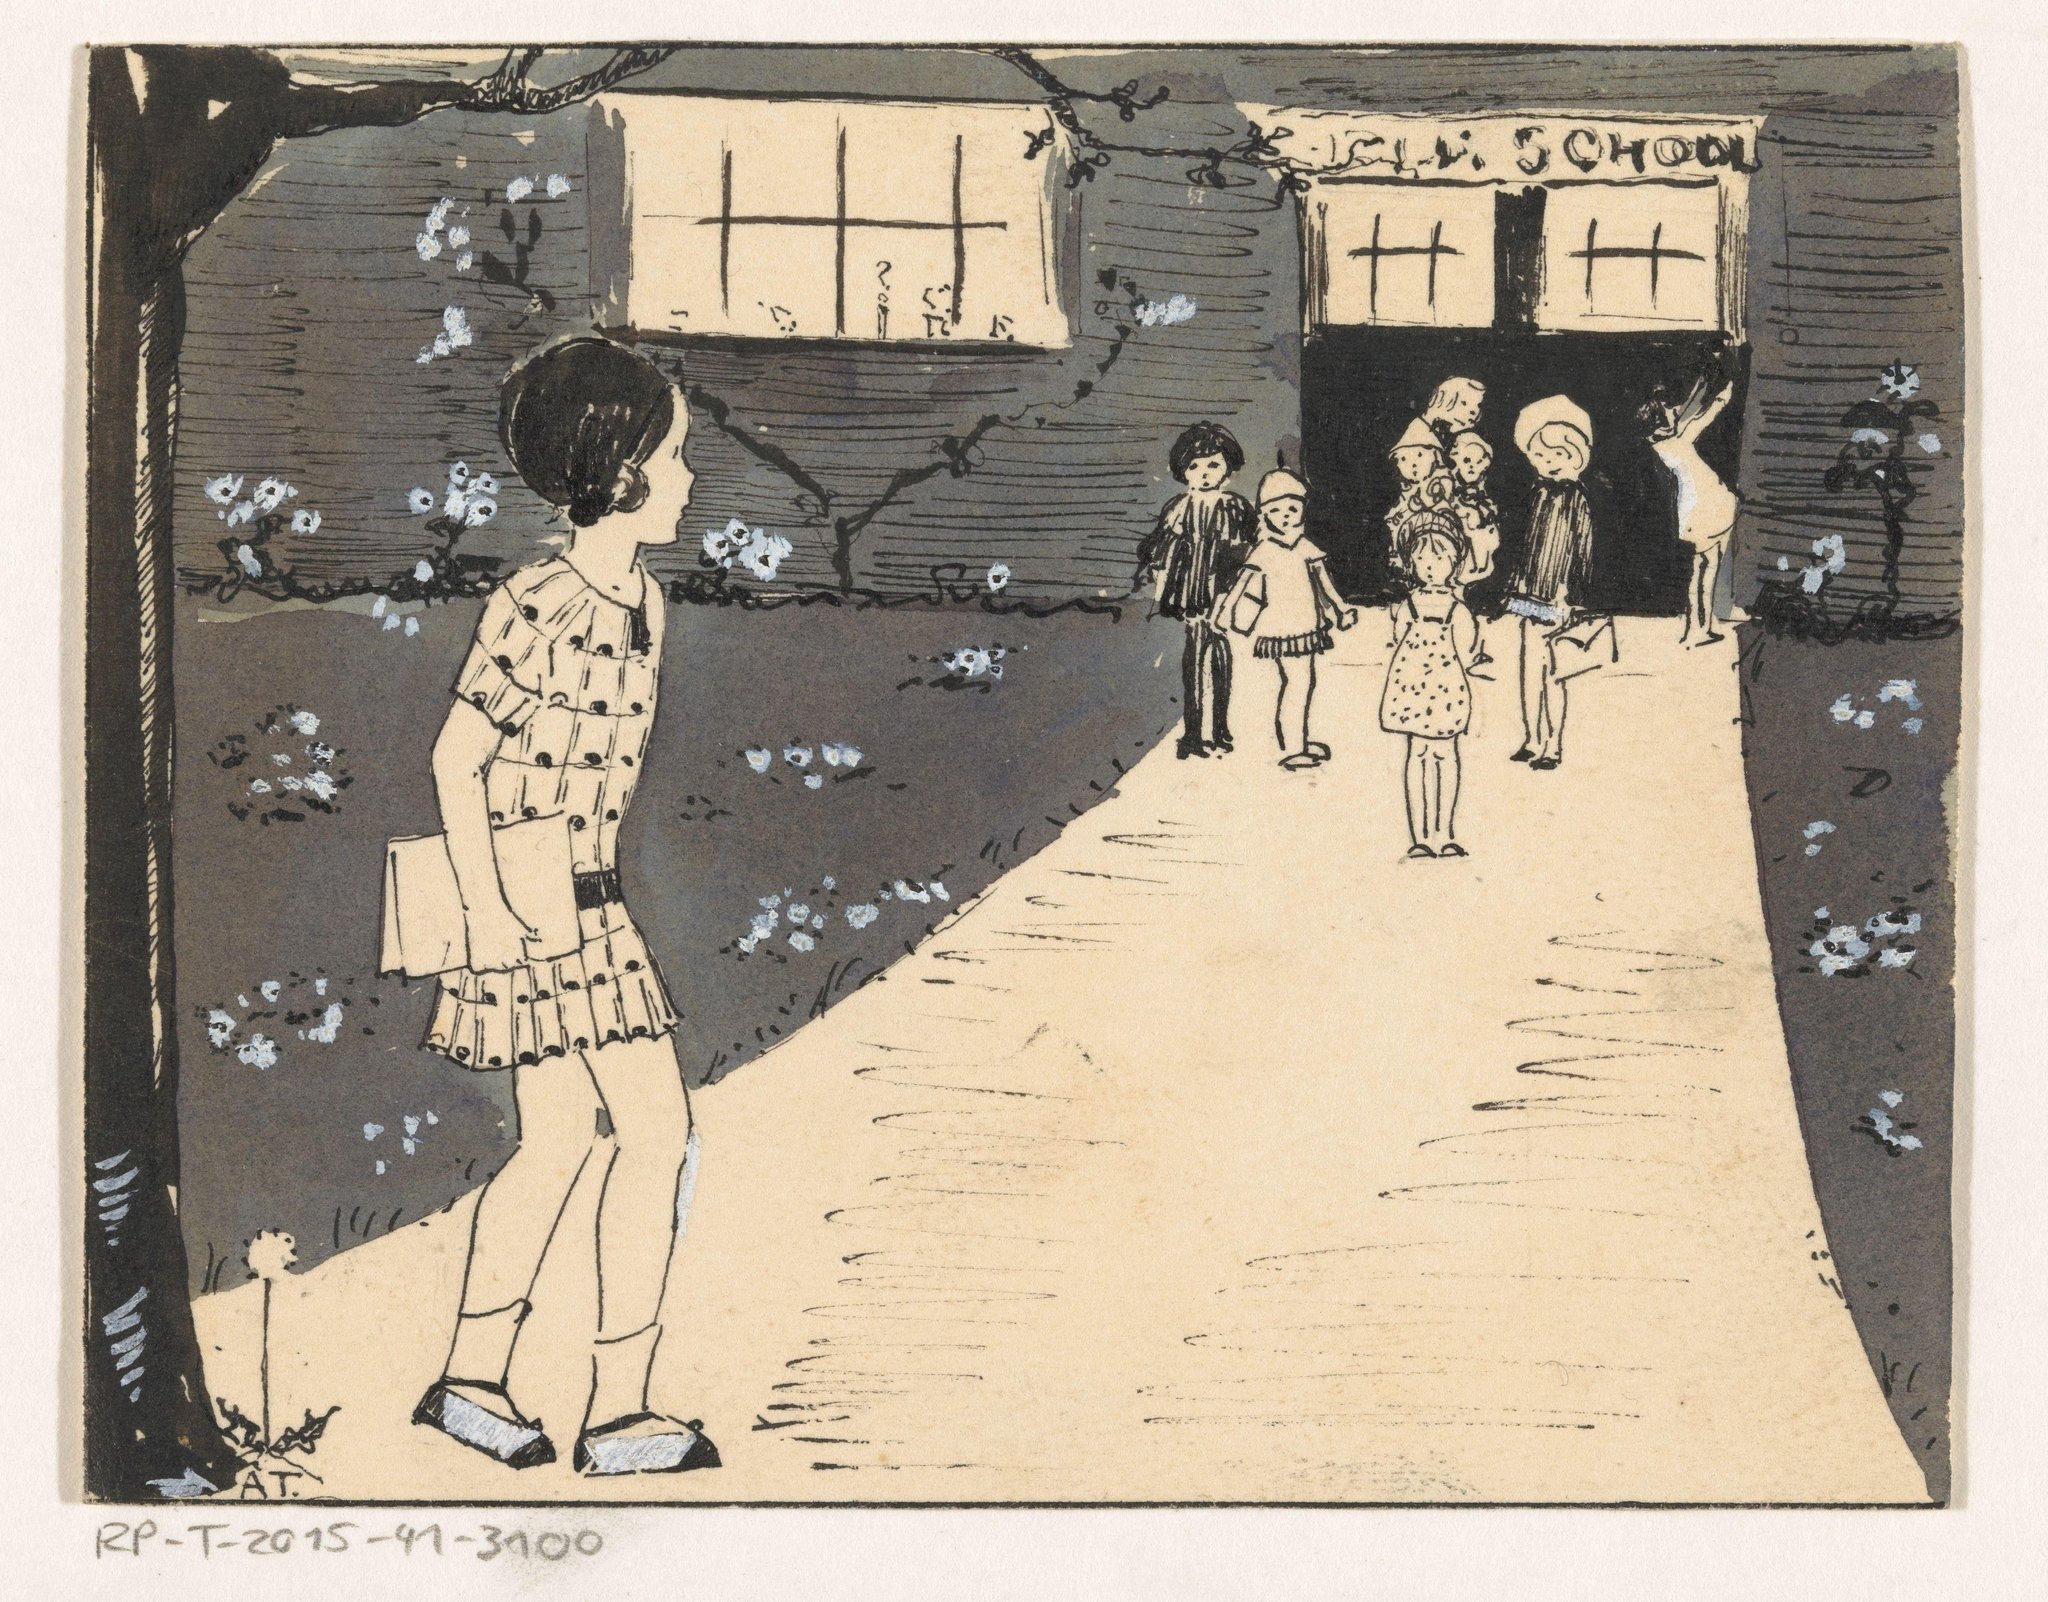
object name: boekillustratie ontwerp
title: Meisje loopt langs school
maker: a. tinbergen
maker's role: draughtsman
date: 1925-1935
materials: paint, ink, paper, pencil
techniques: brush, pen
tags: child, road, path, elementary school; class, form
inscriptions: collector's mark: Lugt 2228a, monogram: ‘AT.’, :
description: Een meisje loopt met een schrift onder de arm over een pad dat naar de ingang van een school leidt. Bij de ingang staat een groep kinderen.